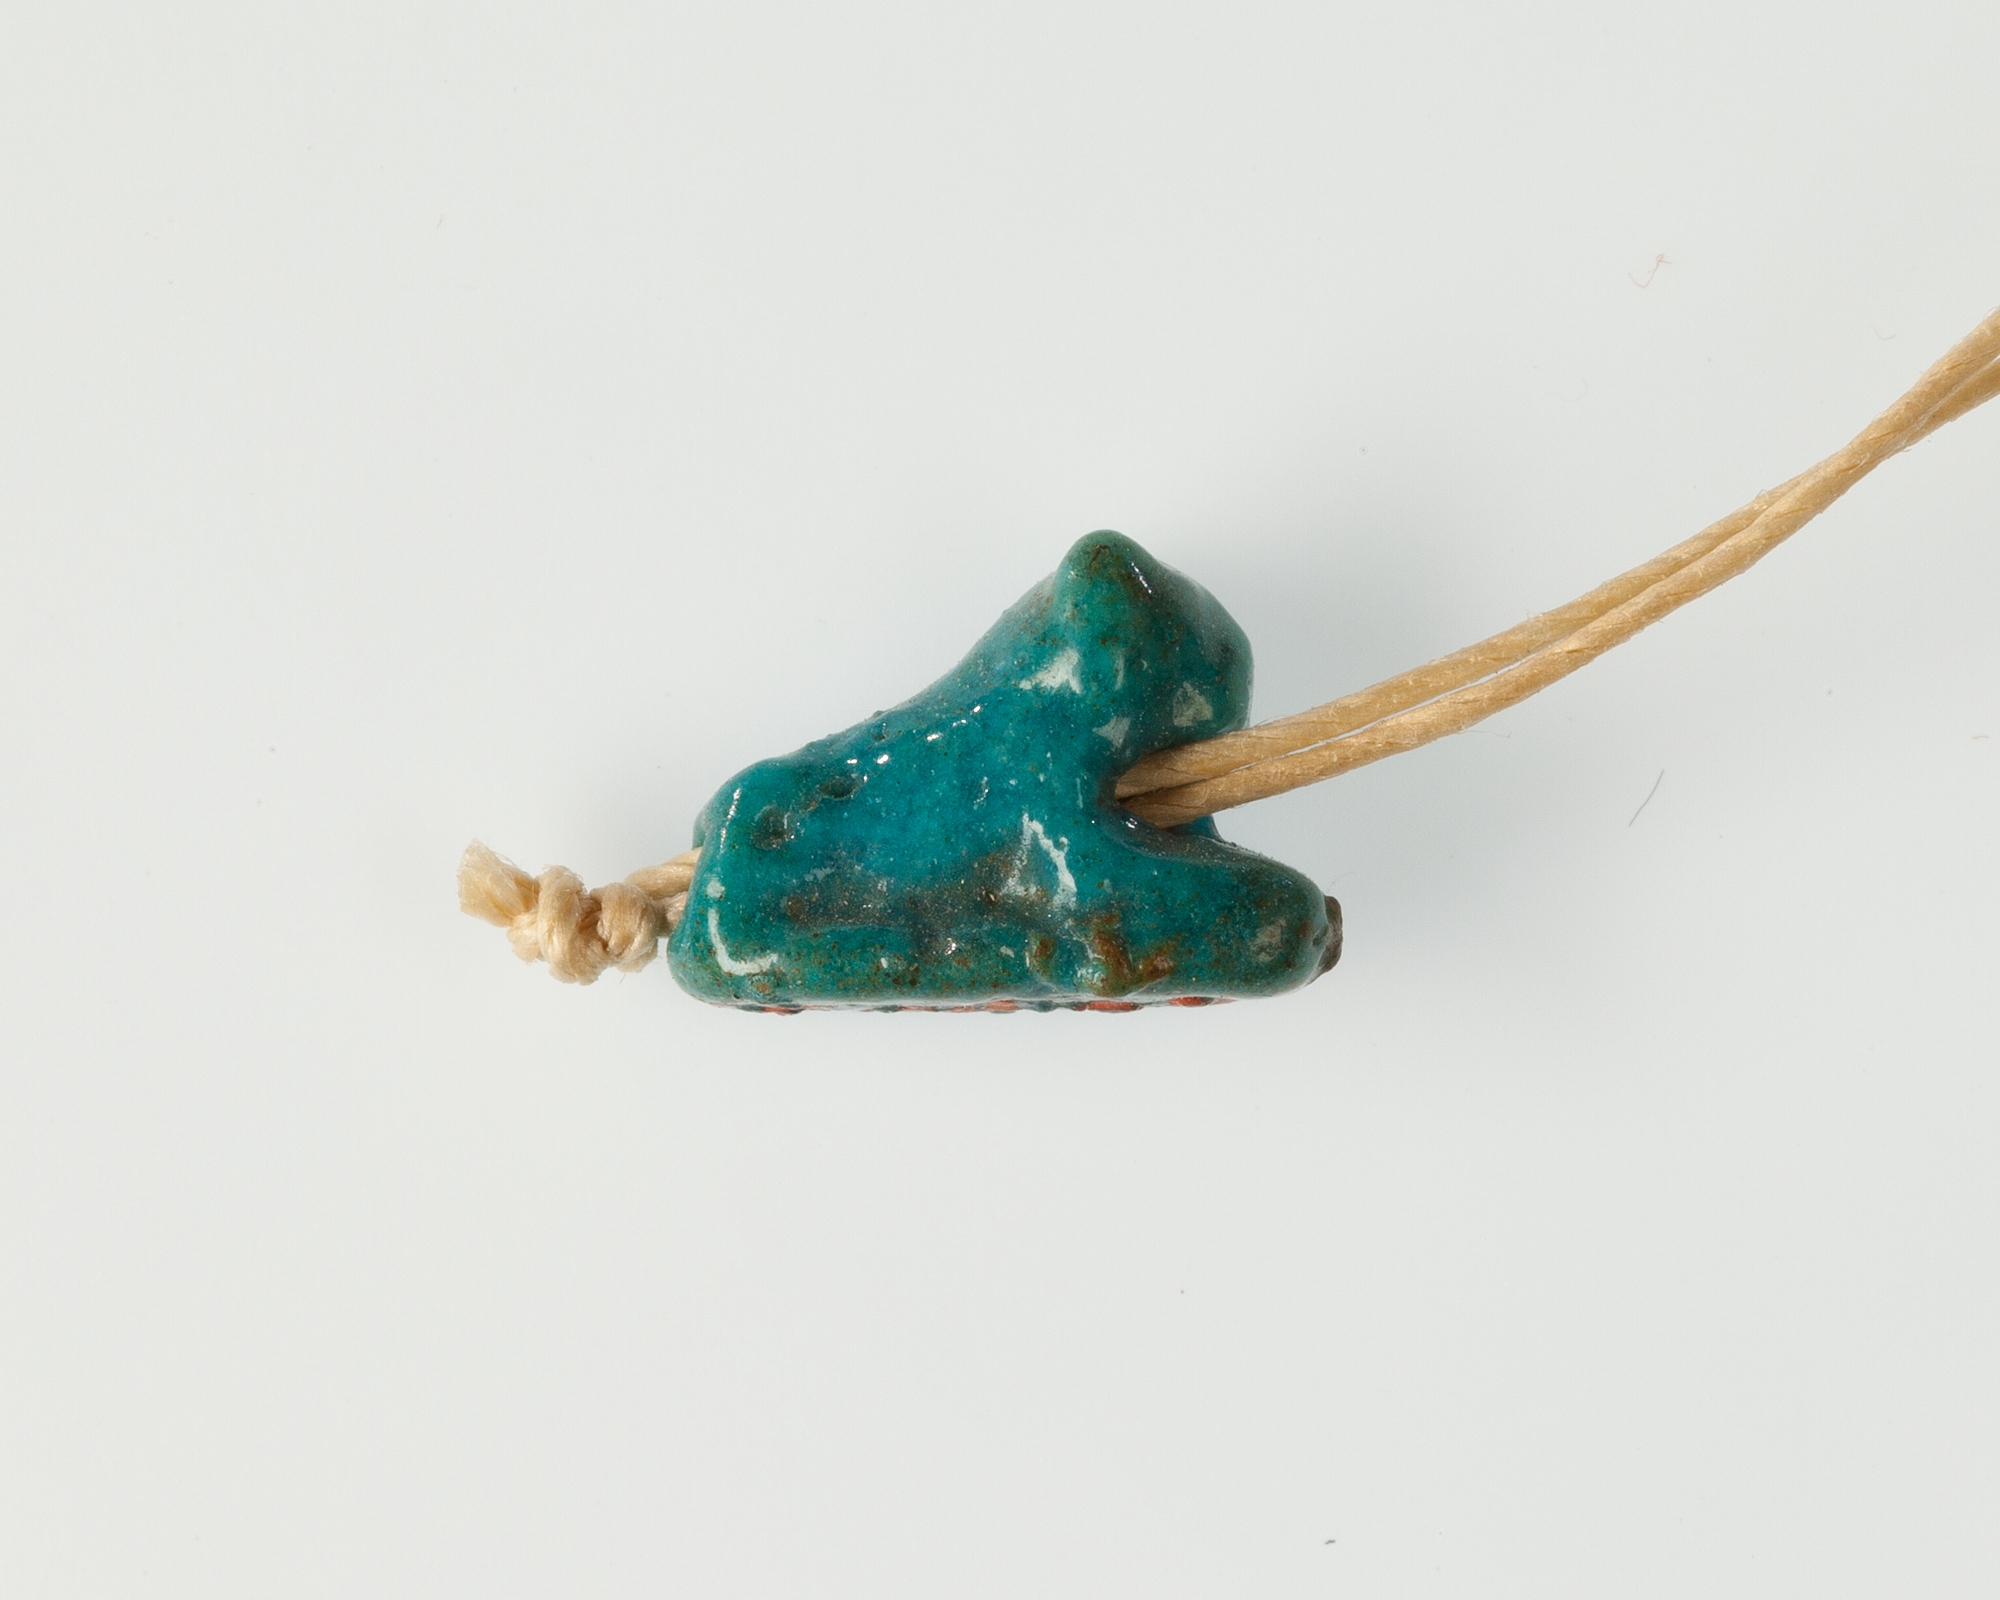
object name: amulet, lion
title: Lion amulet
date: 1635-1458 BCE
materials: faience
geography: egypt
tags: lions